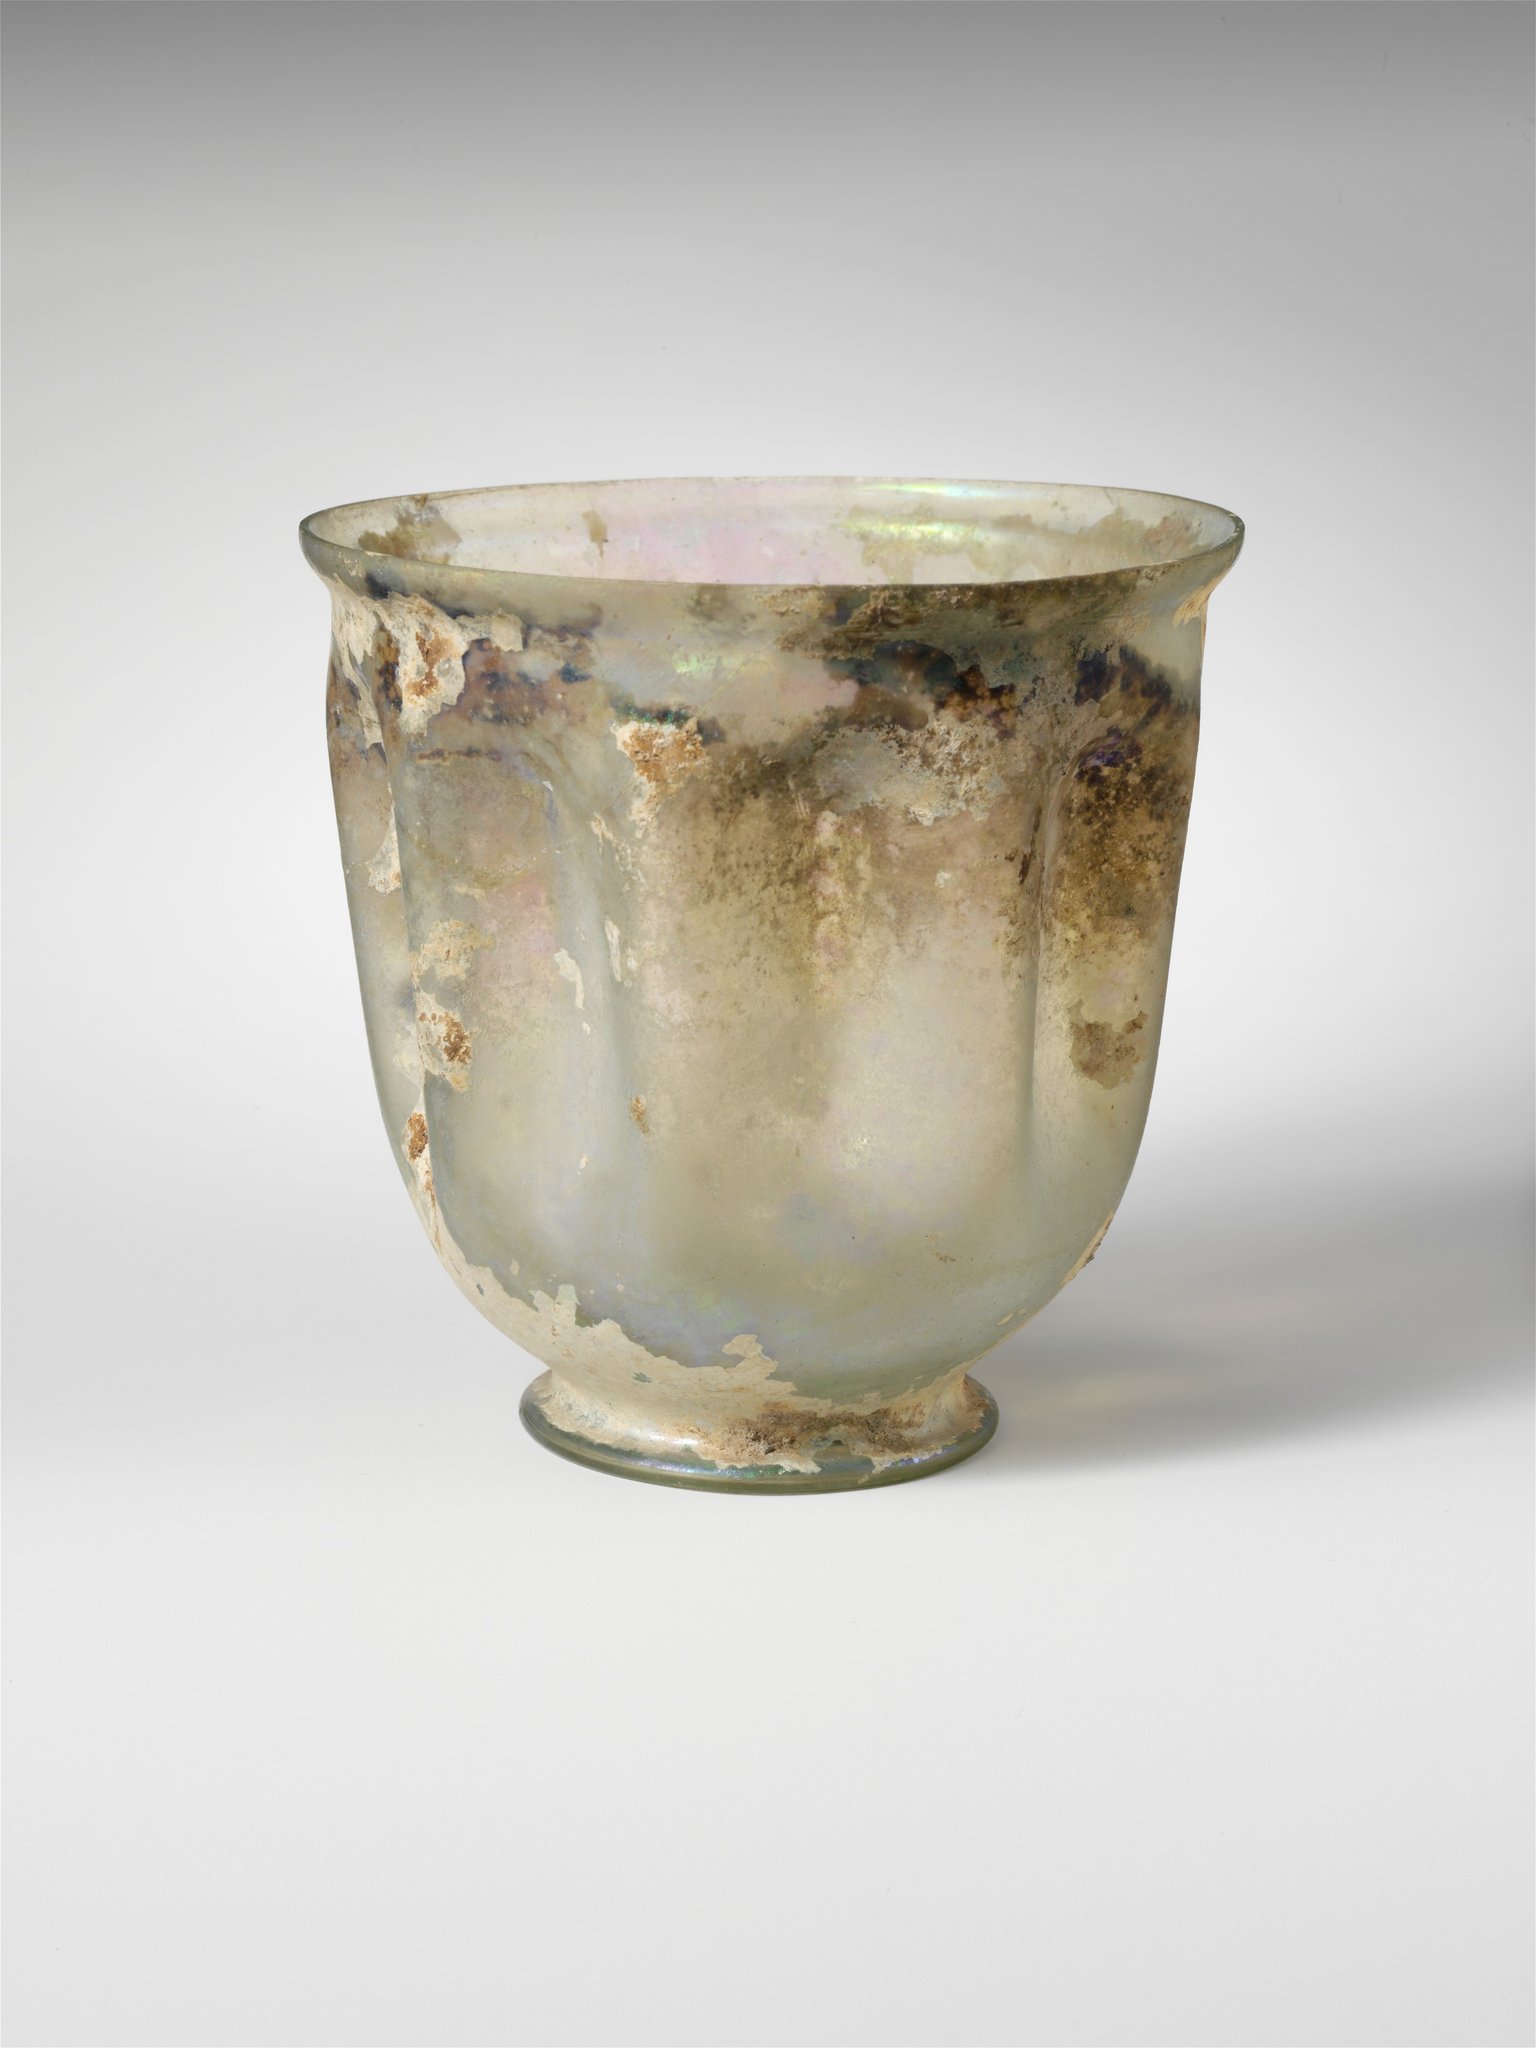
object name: cup, indented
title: Glass cup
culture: roman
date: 34-133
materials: glass